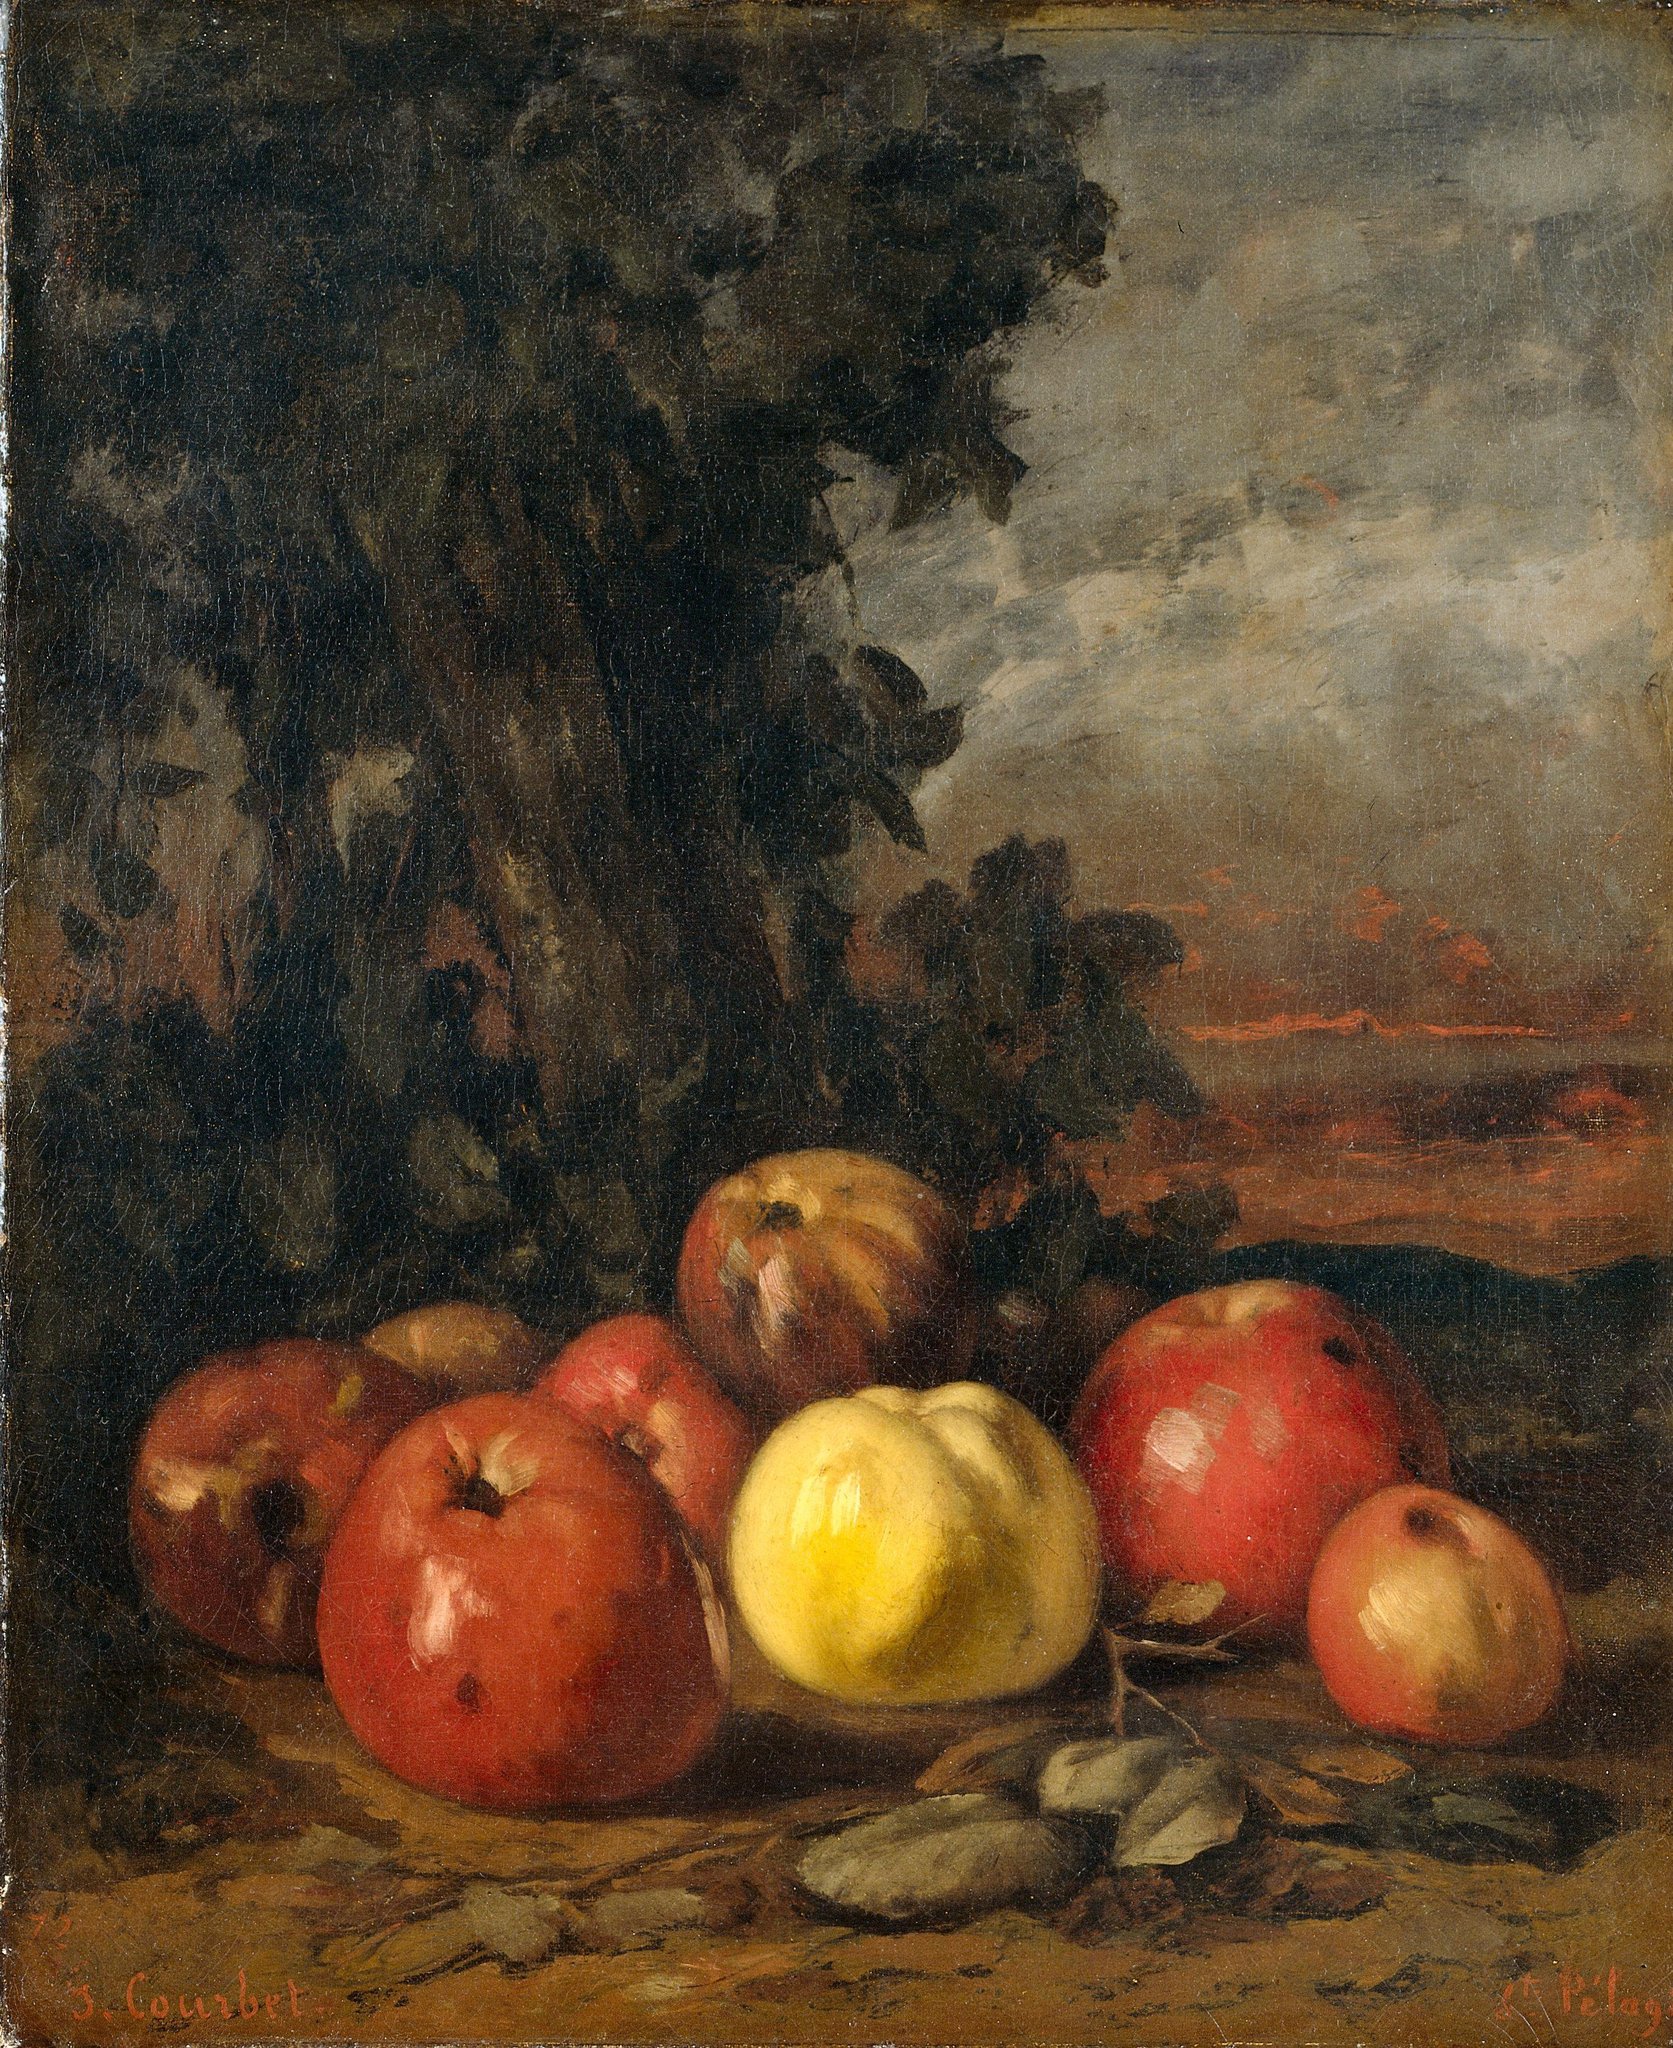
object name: painting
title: Still Life with Apples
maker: gustave courbet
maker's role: print maker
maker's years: 1819-1877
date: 1871-1872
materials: canvas, oil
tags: fruits: apple, fruit, still life of related objects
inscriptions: signature and date: ‘G. Courbet. 72.’, inscription: ‘St. Pélagie’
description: Ondanks dat het schilderij 1872 gedateerd is is het schilderij mogelijk eerder gemaakt: Courbet zat in 1871 zes maanden lang in de gevangenis en maakte in die tijd veel stillevens van appels (de Leeuw 2000). In 1872 stuurde Courbet dit schilderij naar de Salon op, maar werd afgewezen (Vergeest).